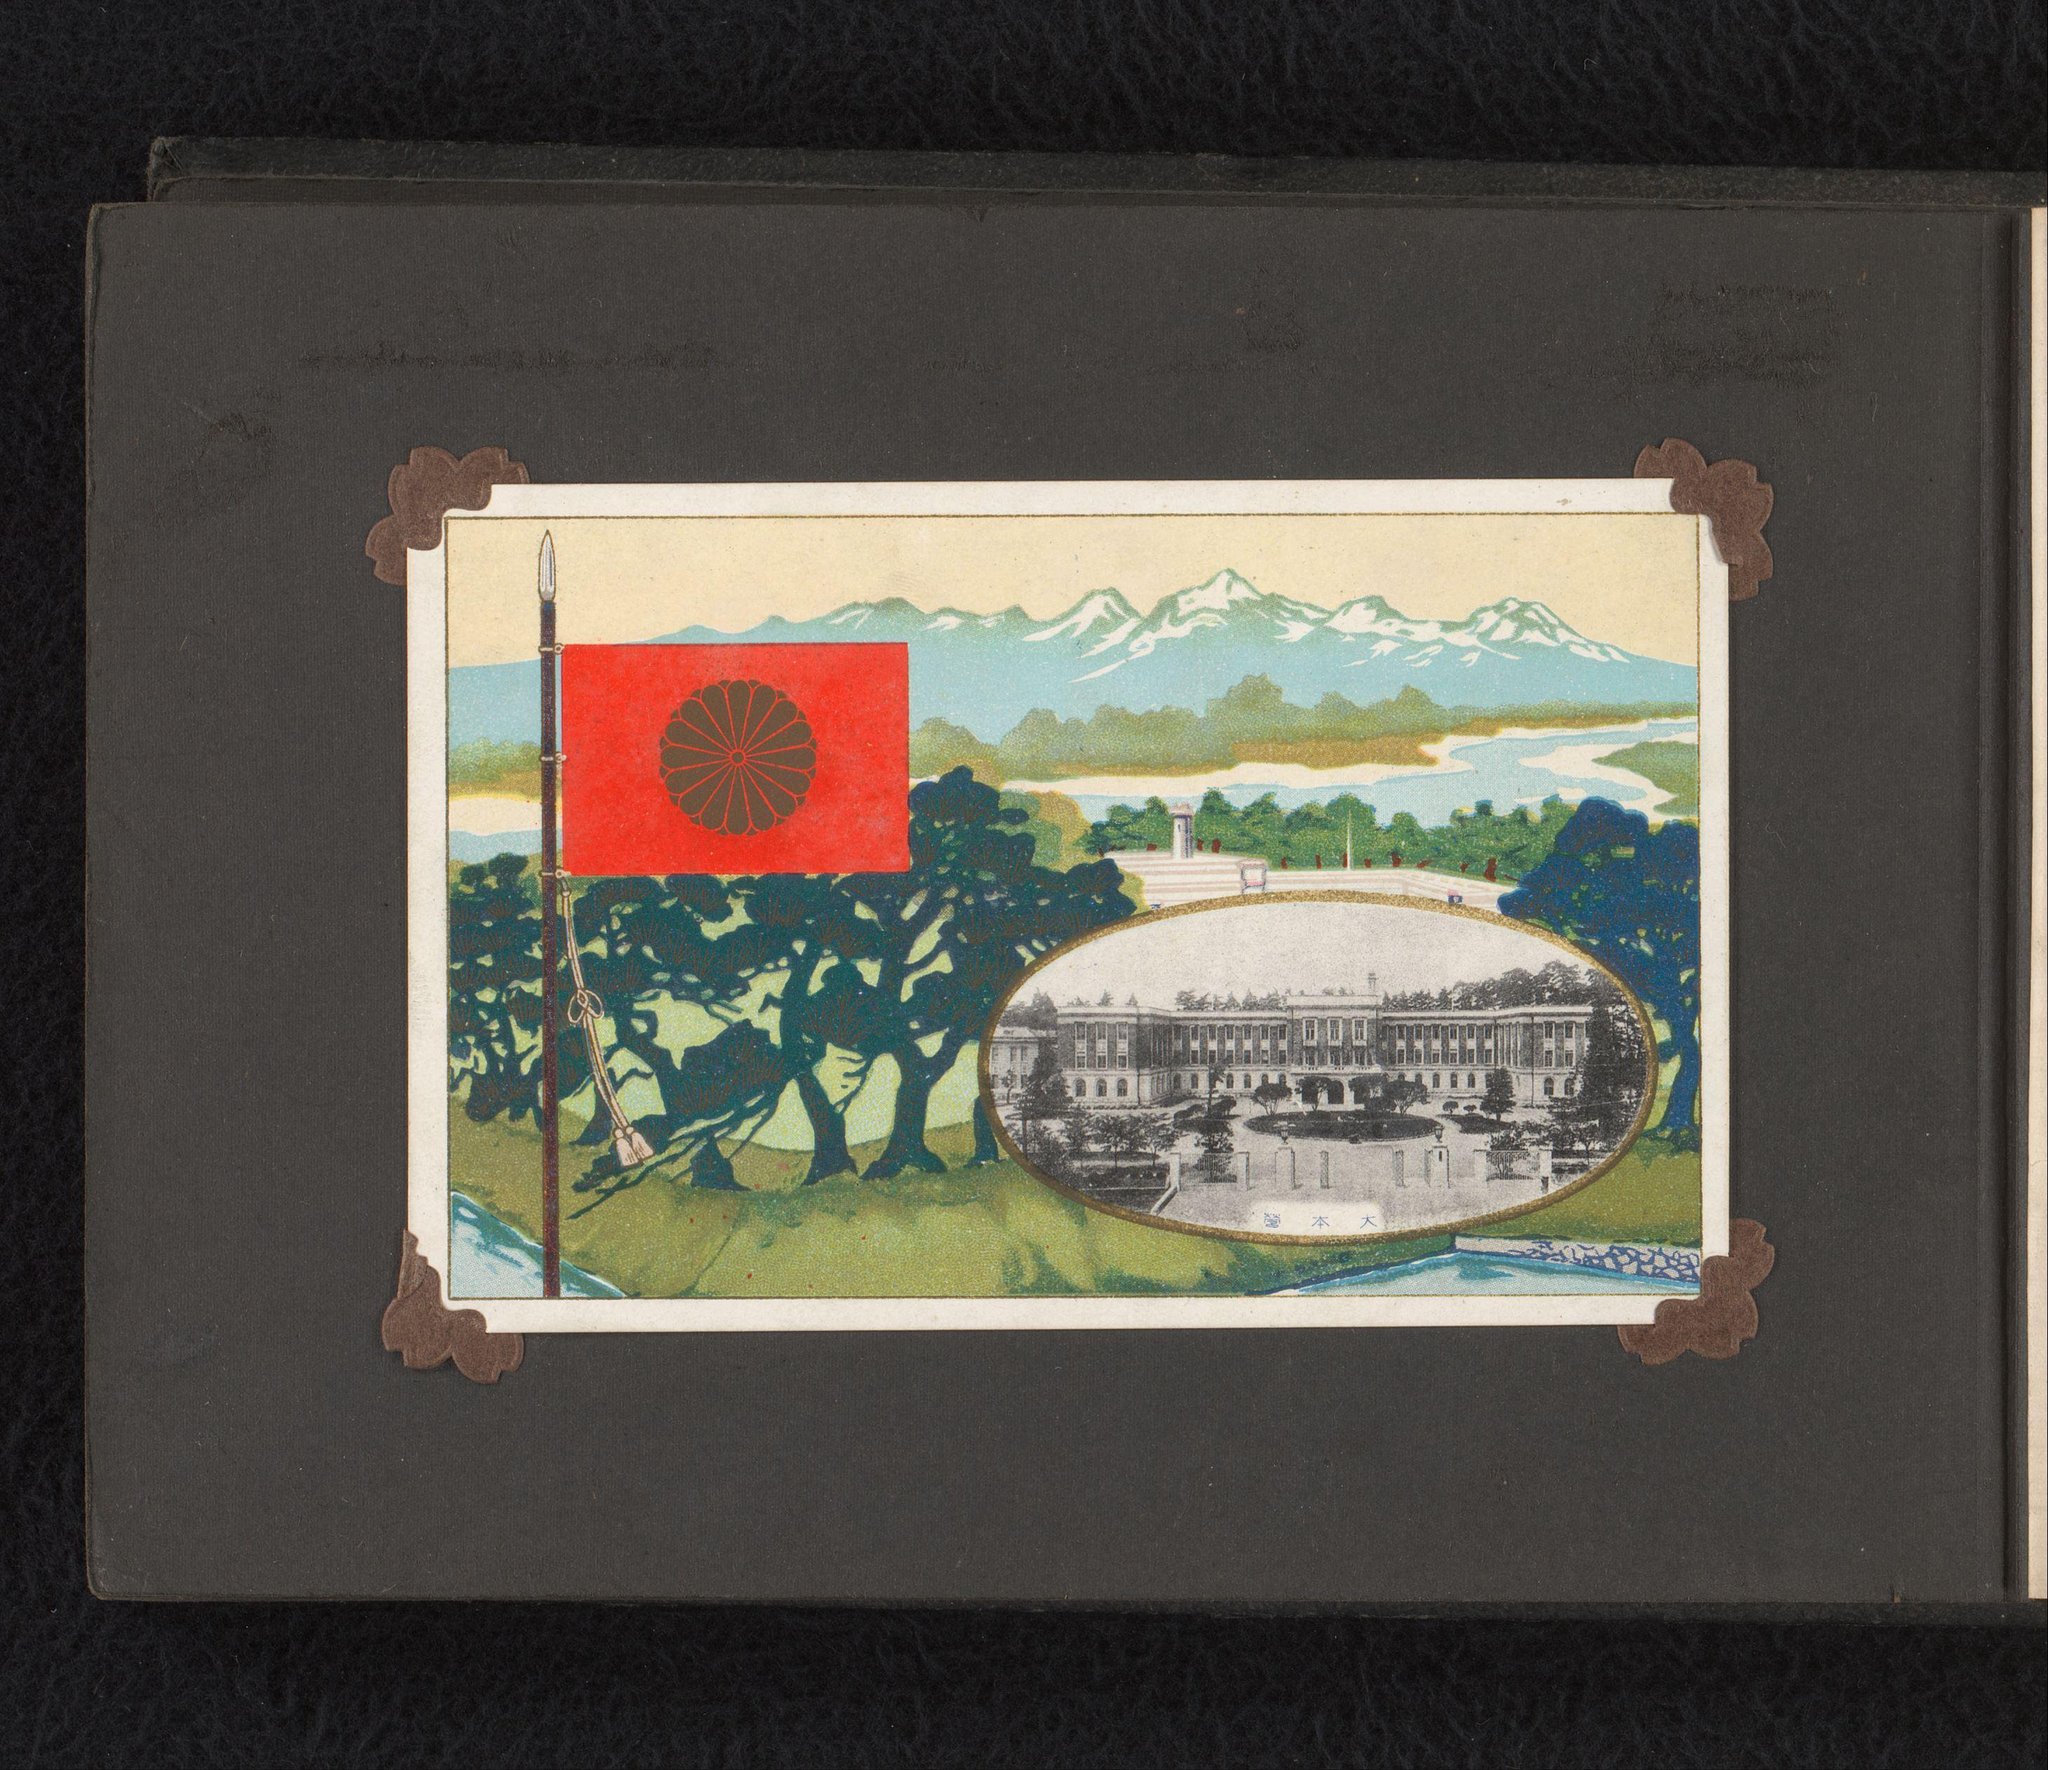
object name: print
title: Keizerlijk Japans paleis tegen een landschap met bergen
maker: Anonymous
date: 1937-1941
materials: paper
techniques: photograph, lithograph, printing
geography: japan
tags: palace, japan